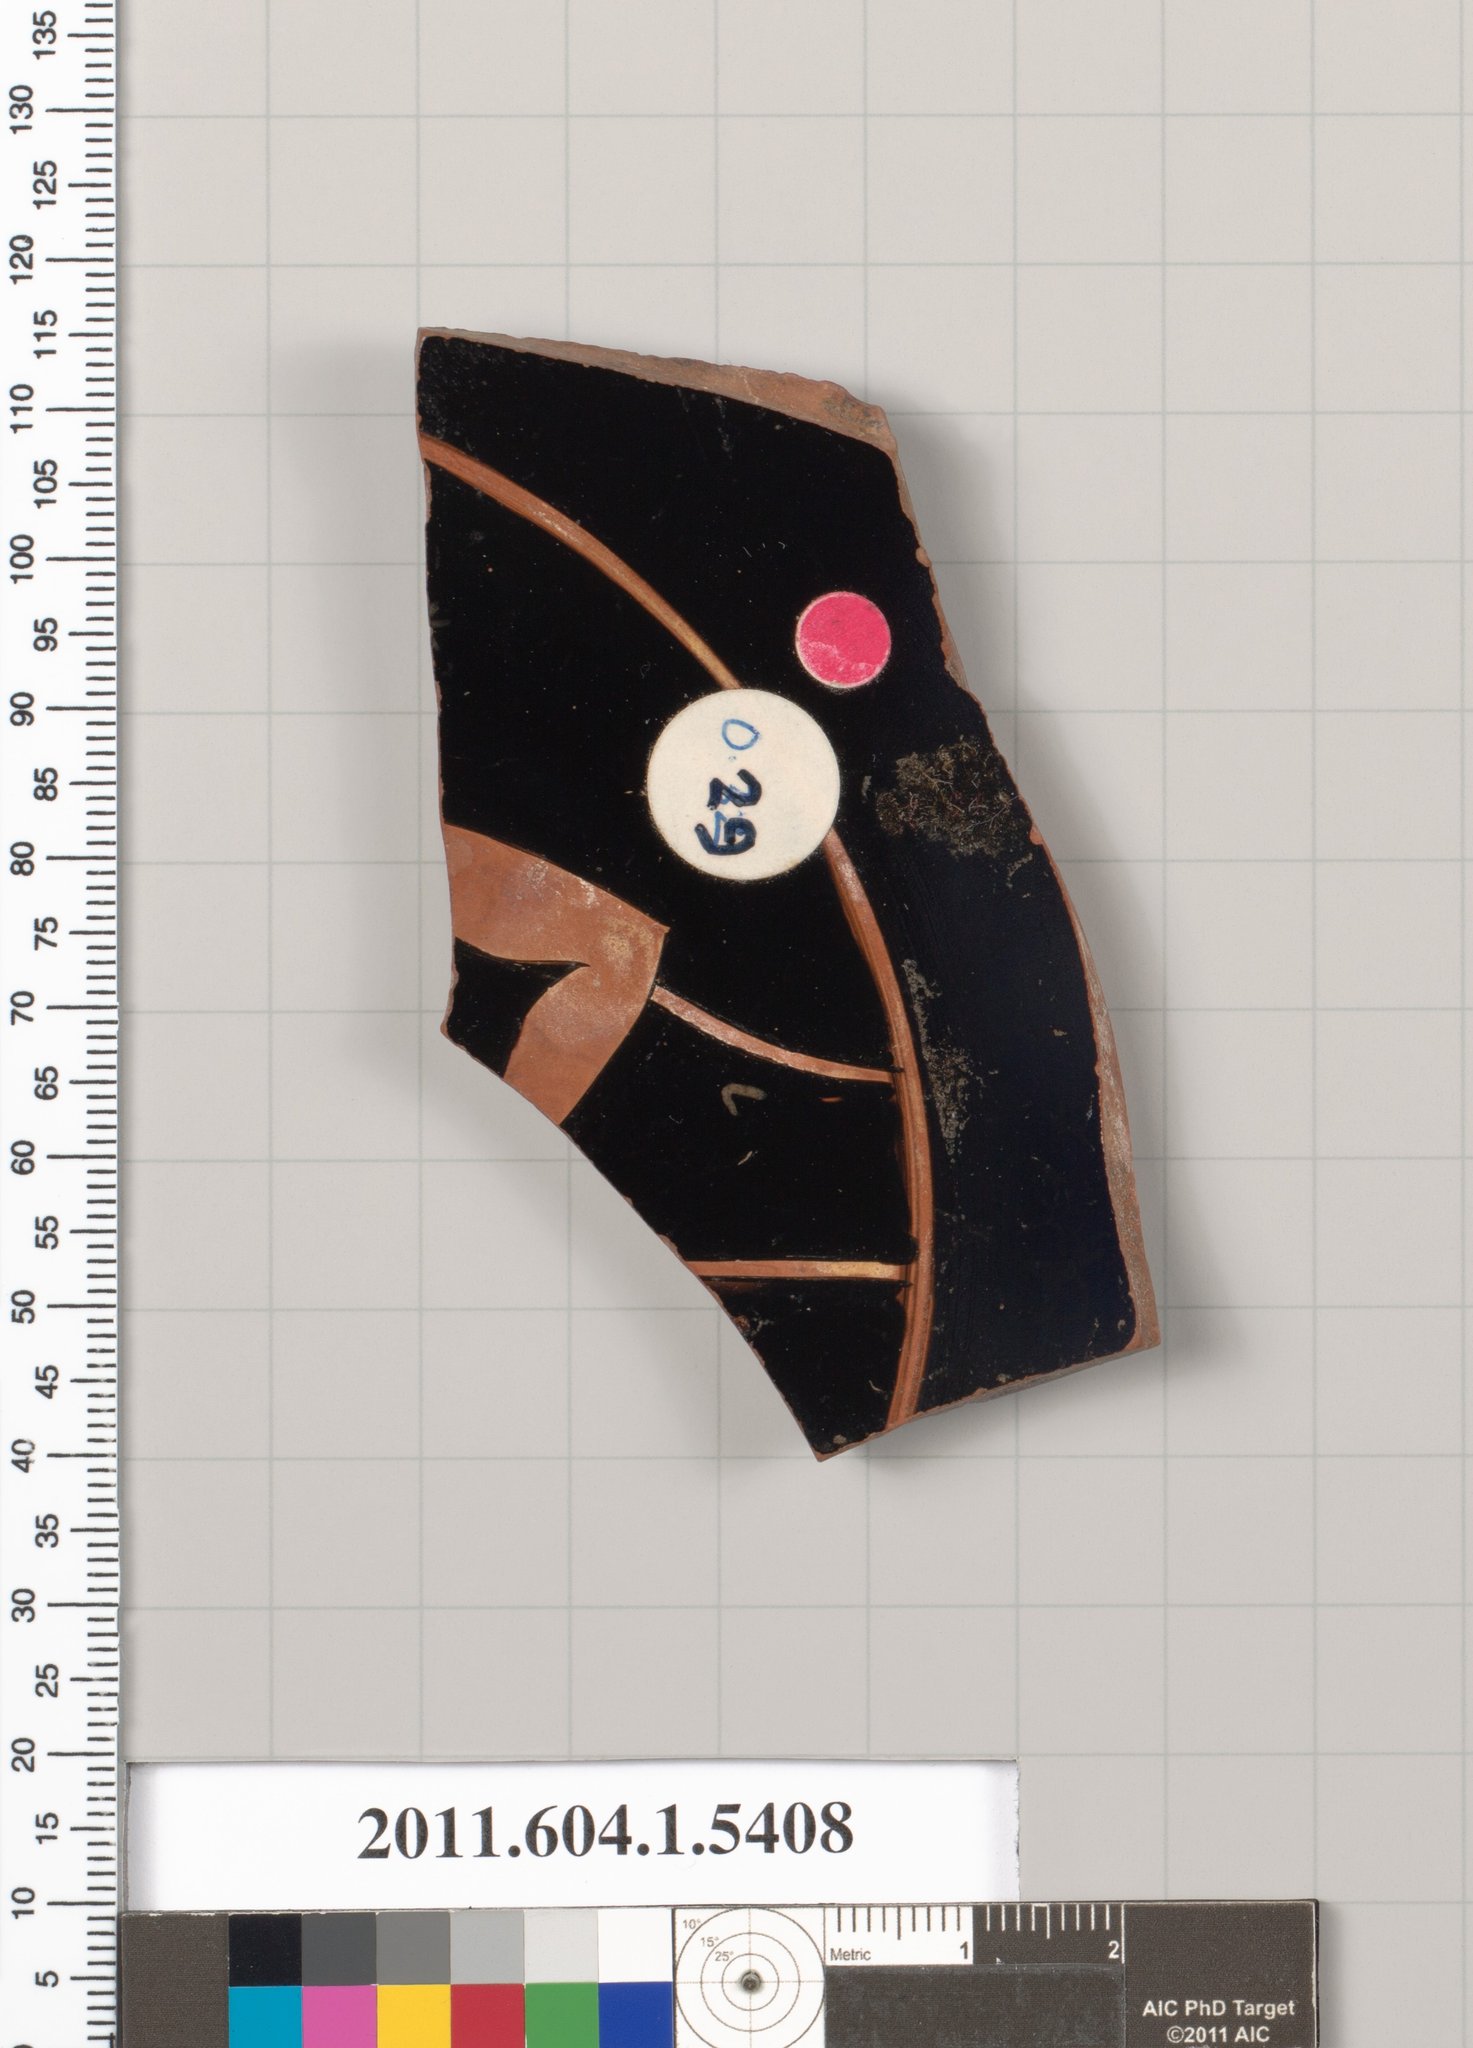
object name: kylix fragment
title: Terracotta fragment of a kylix (drinking cup)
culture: greek, attic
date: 510-490 BCE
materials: terracotta